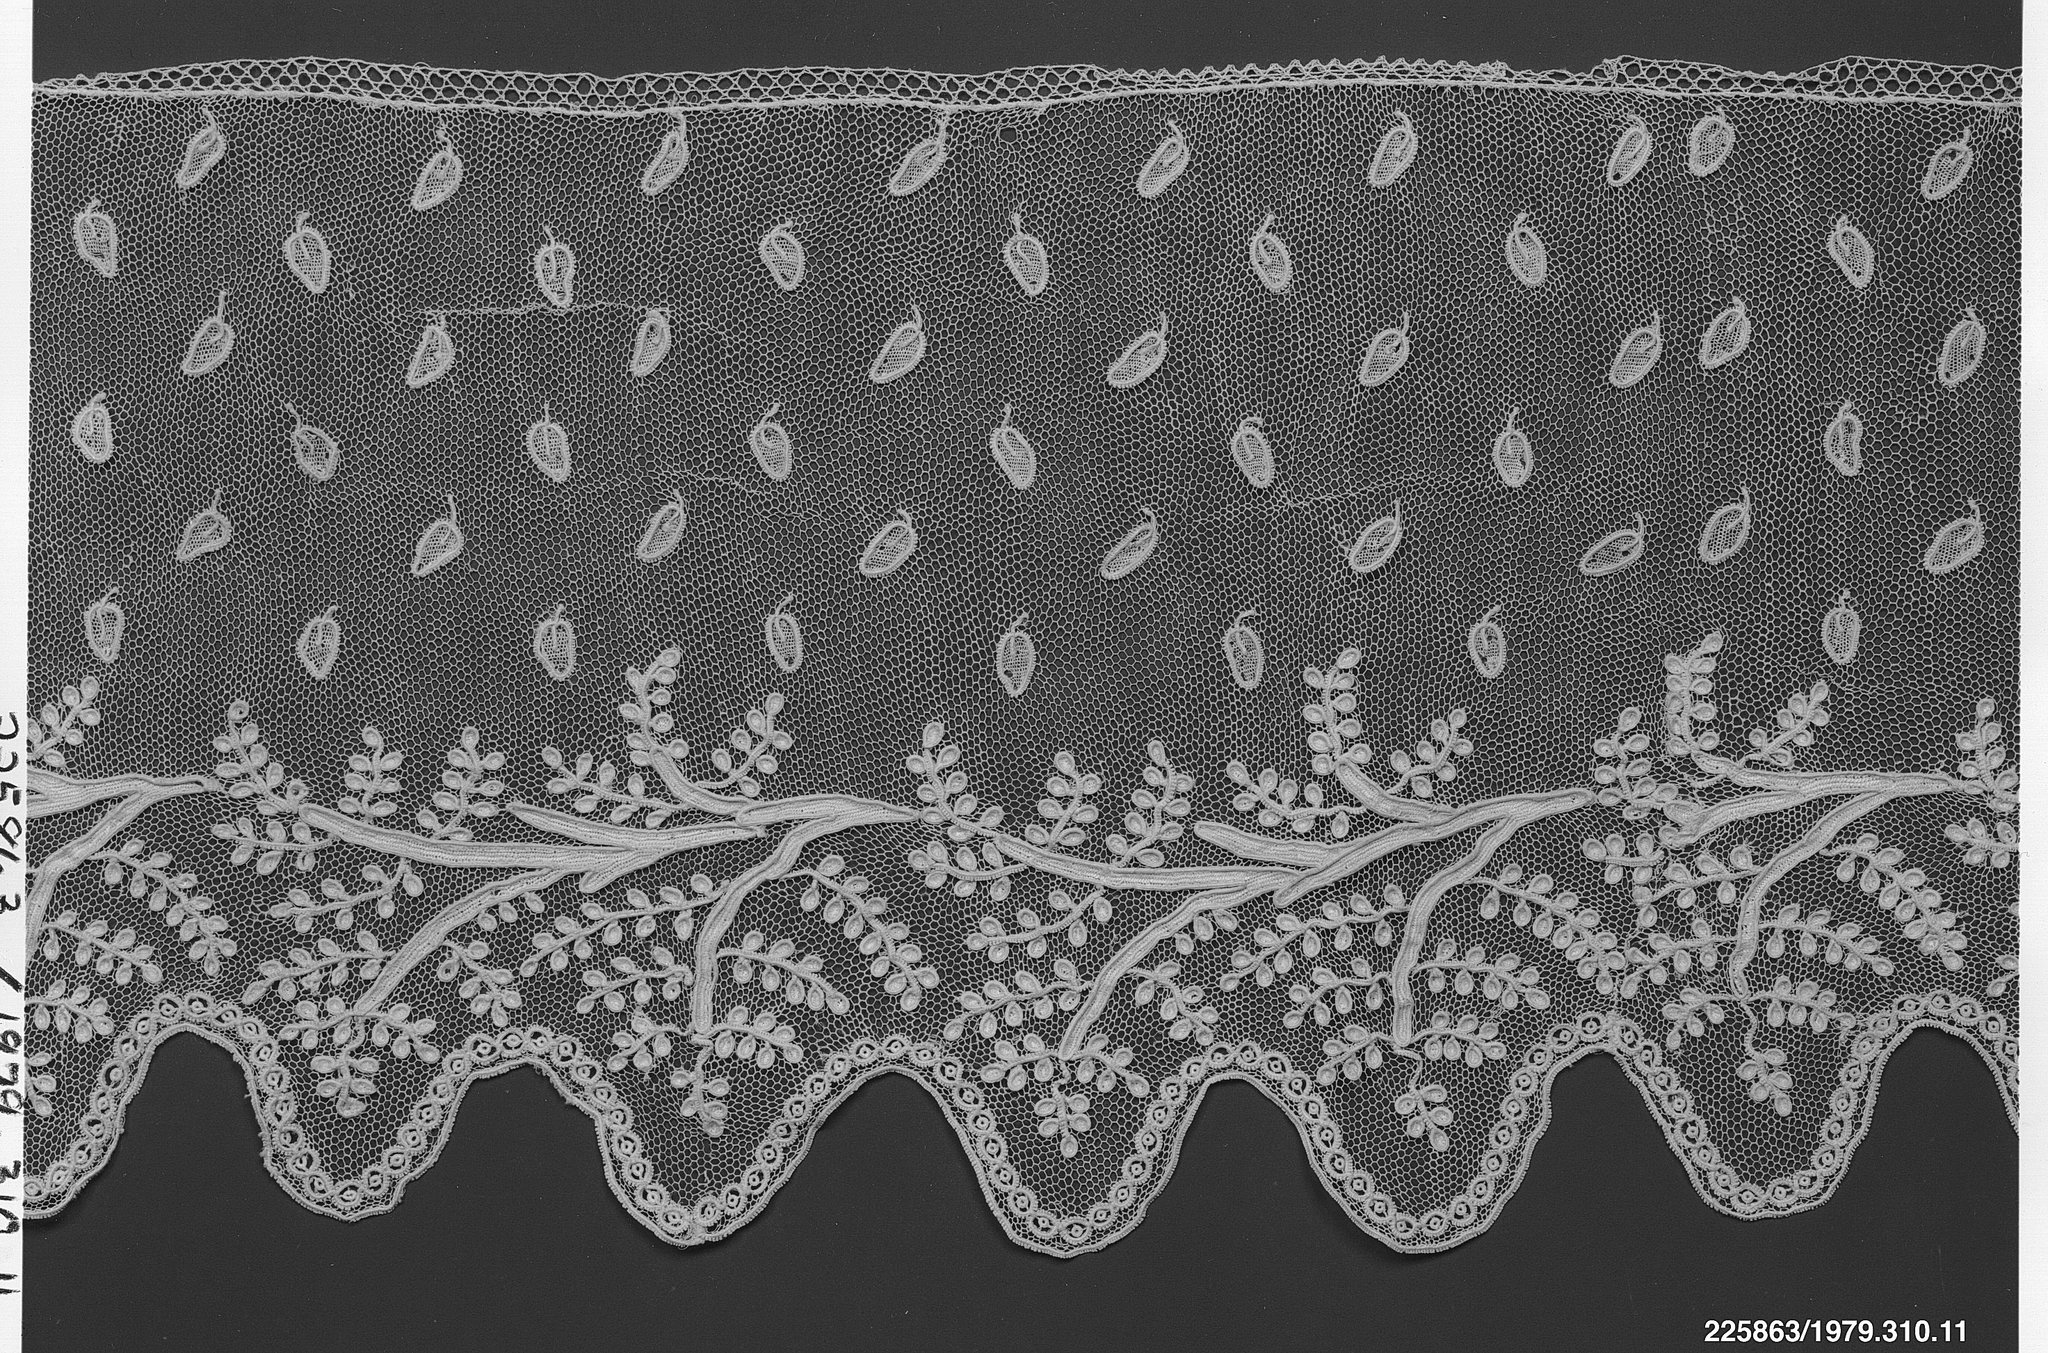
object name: edging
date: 1767-1833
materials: hair, linen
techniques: lace